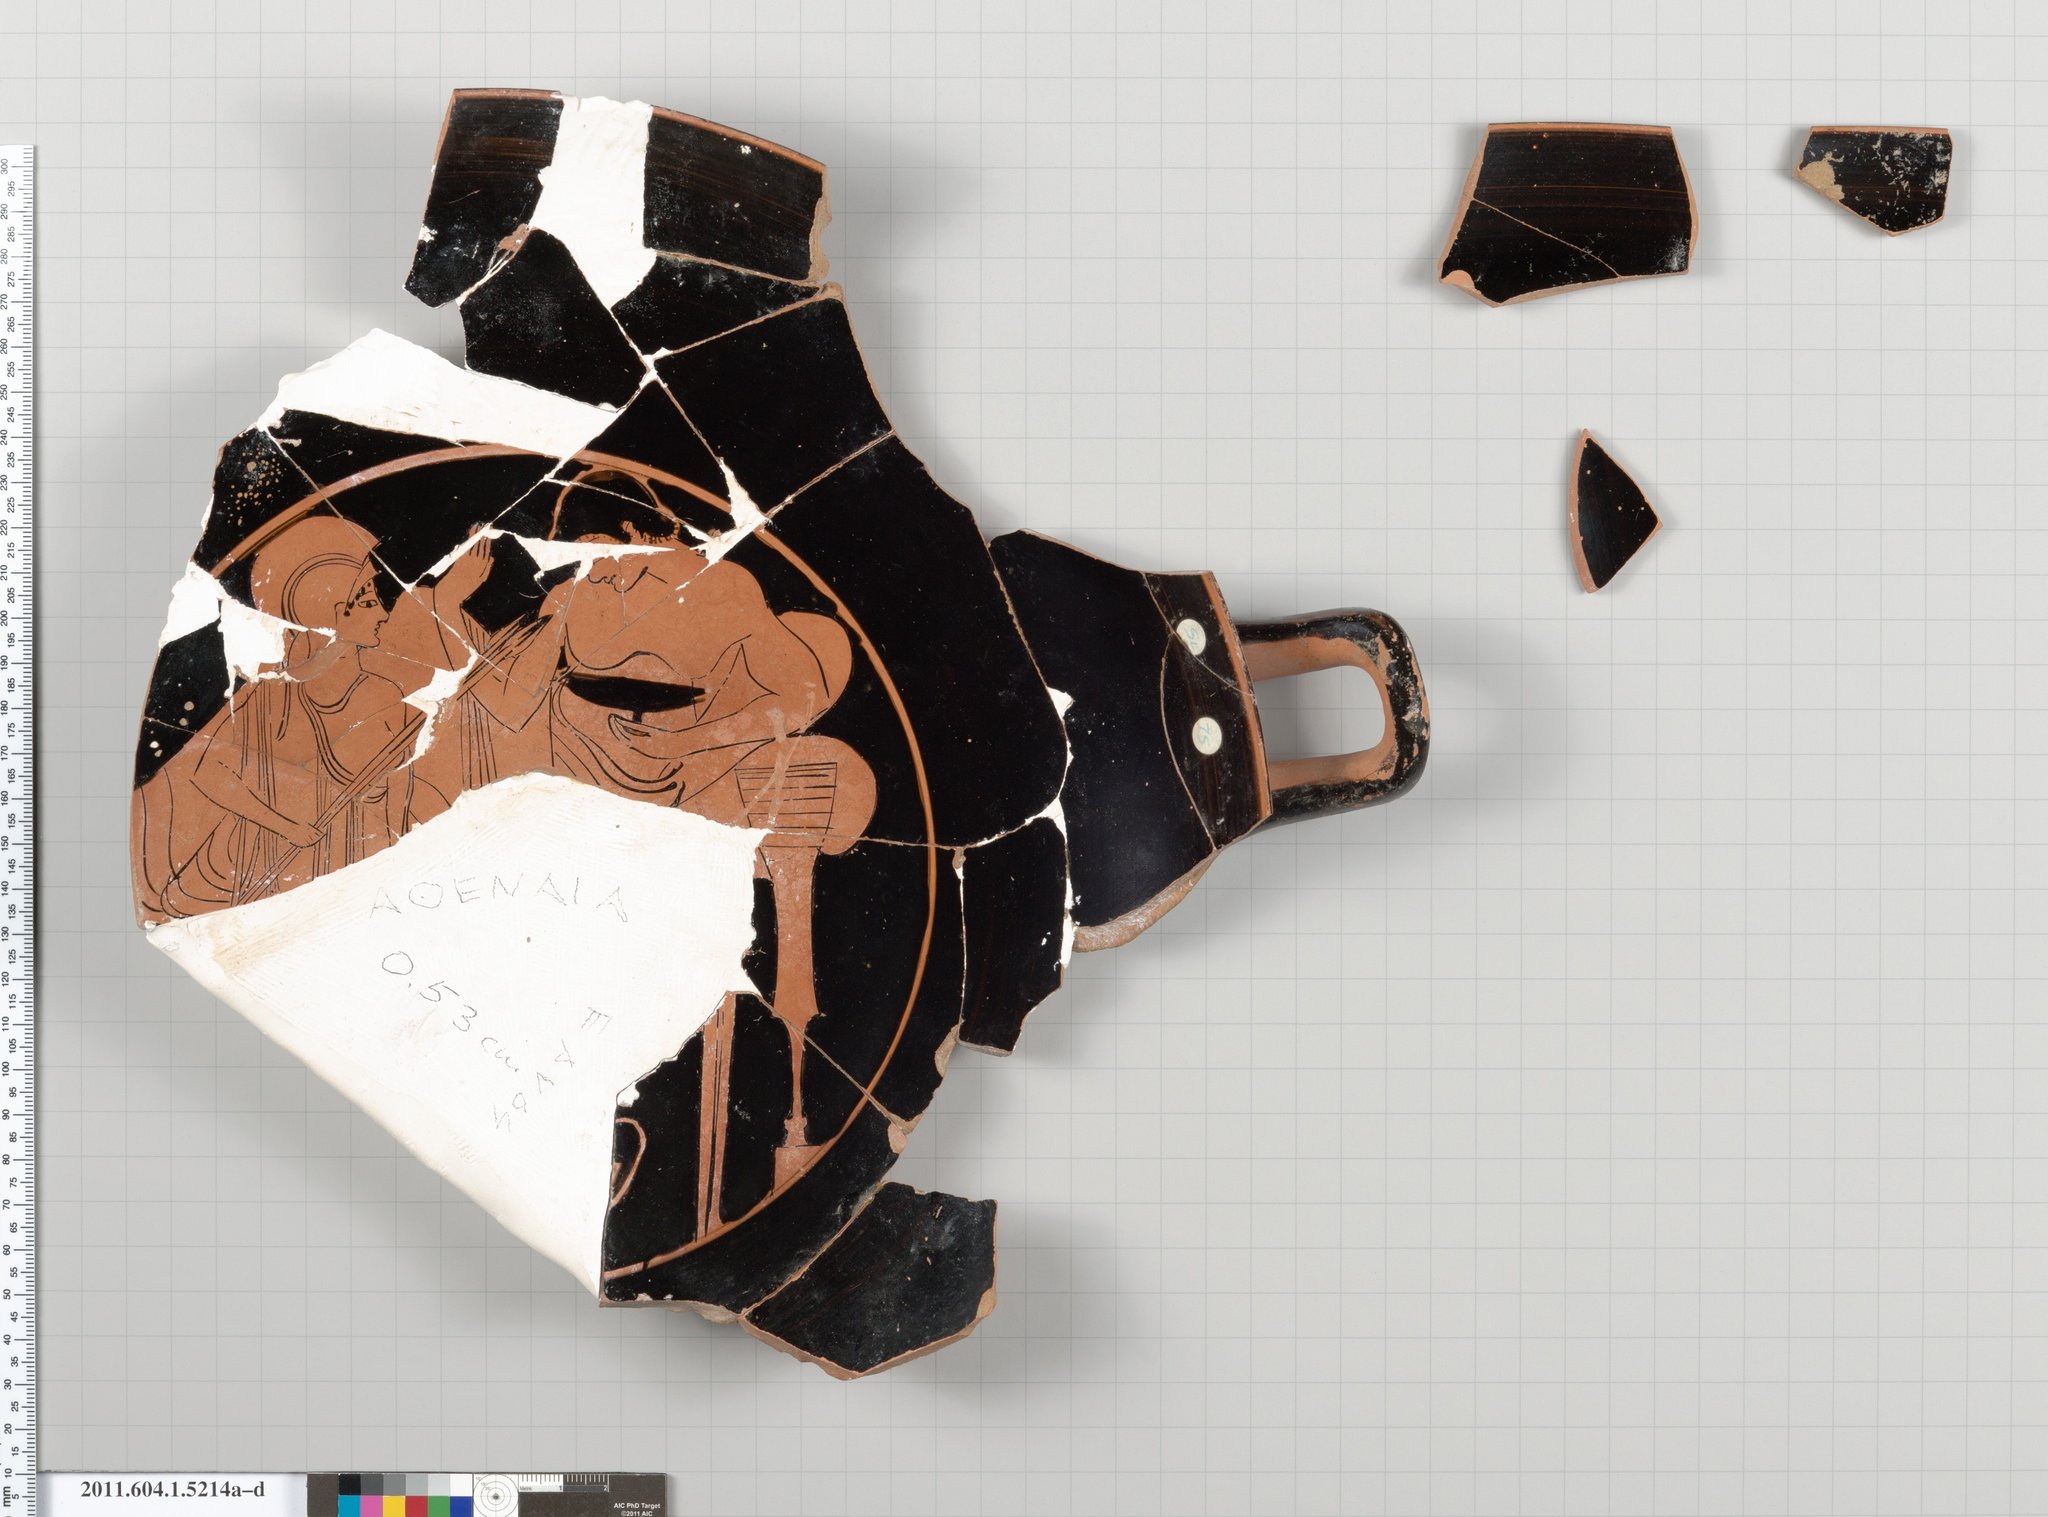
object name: kylix fragment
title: Terracotta fragments of a kylix (drinking cup)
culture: greek, attic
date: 520-510 BCE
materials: terracotta